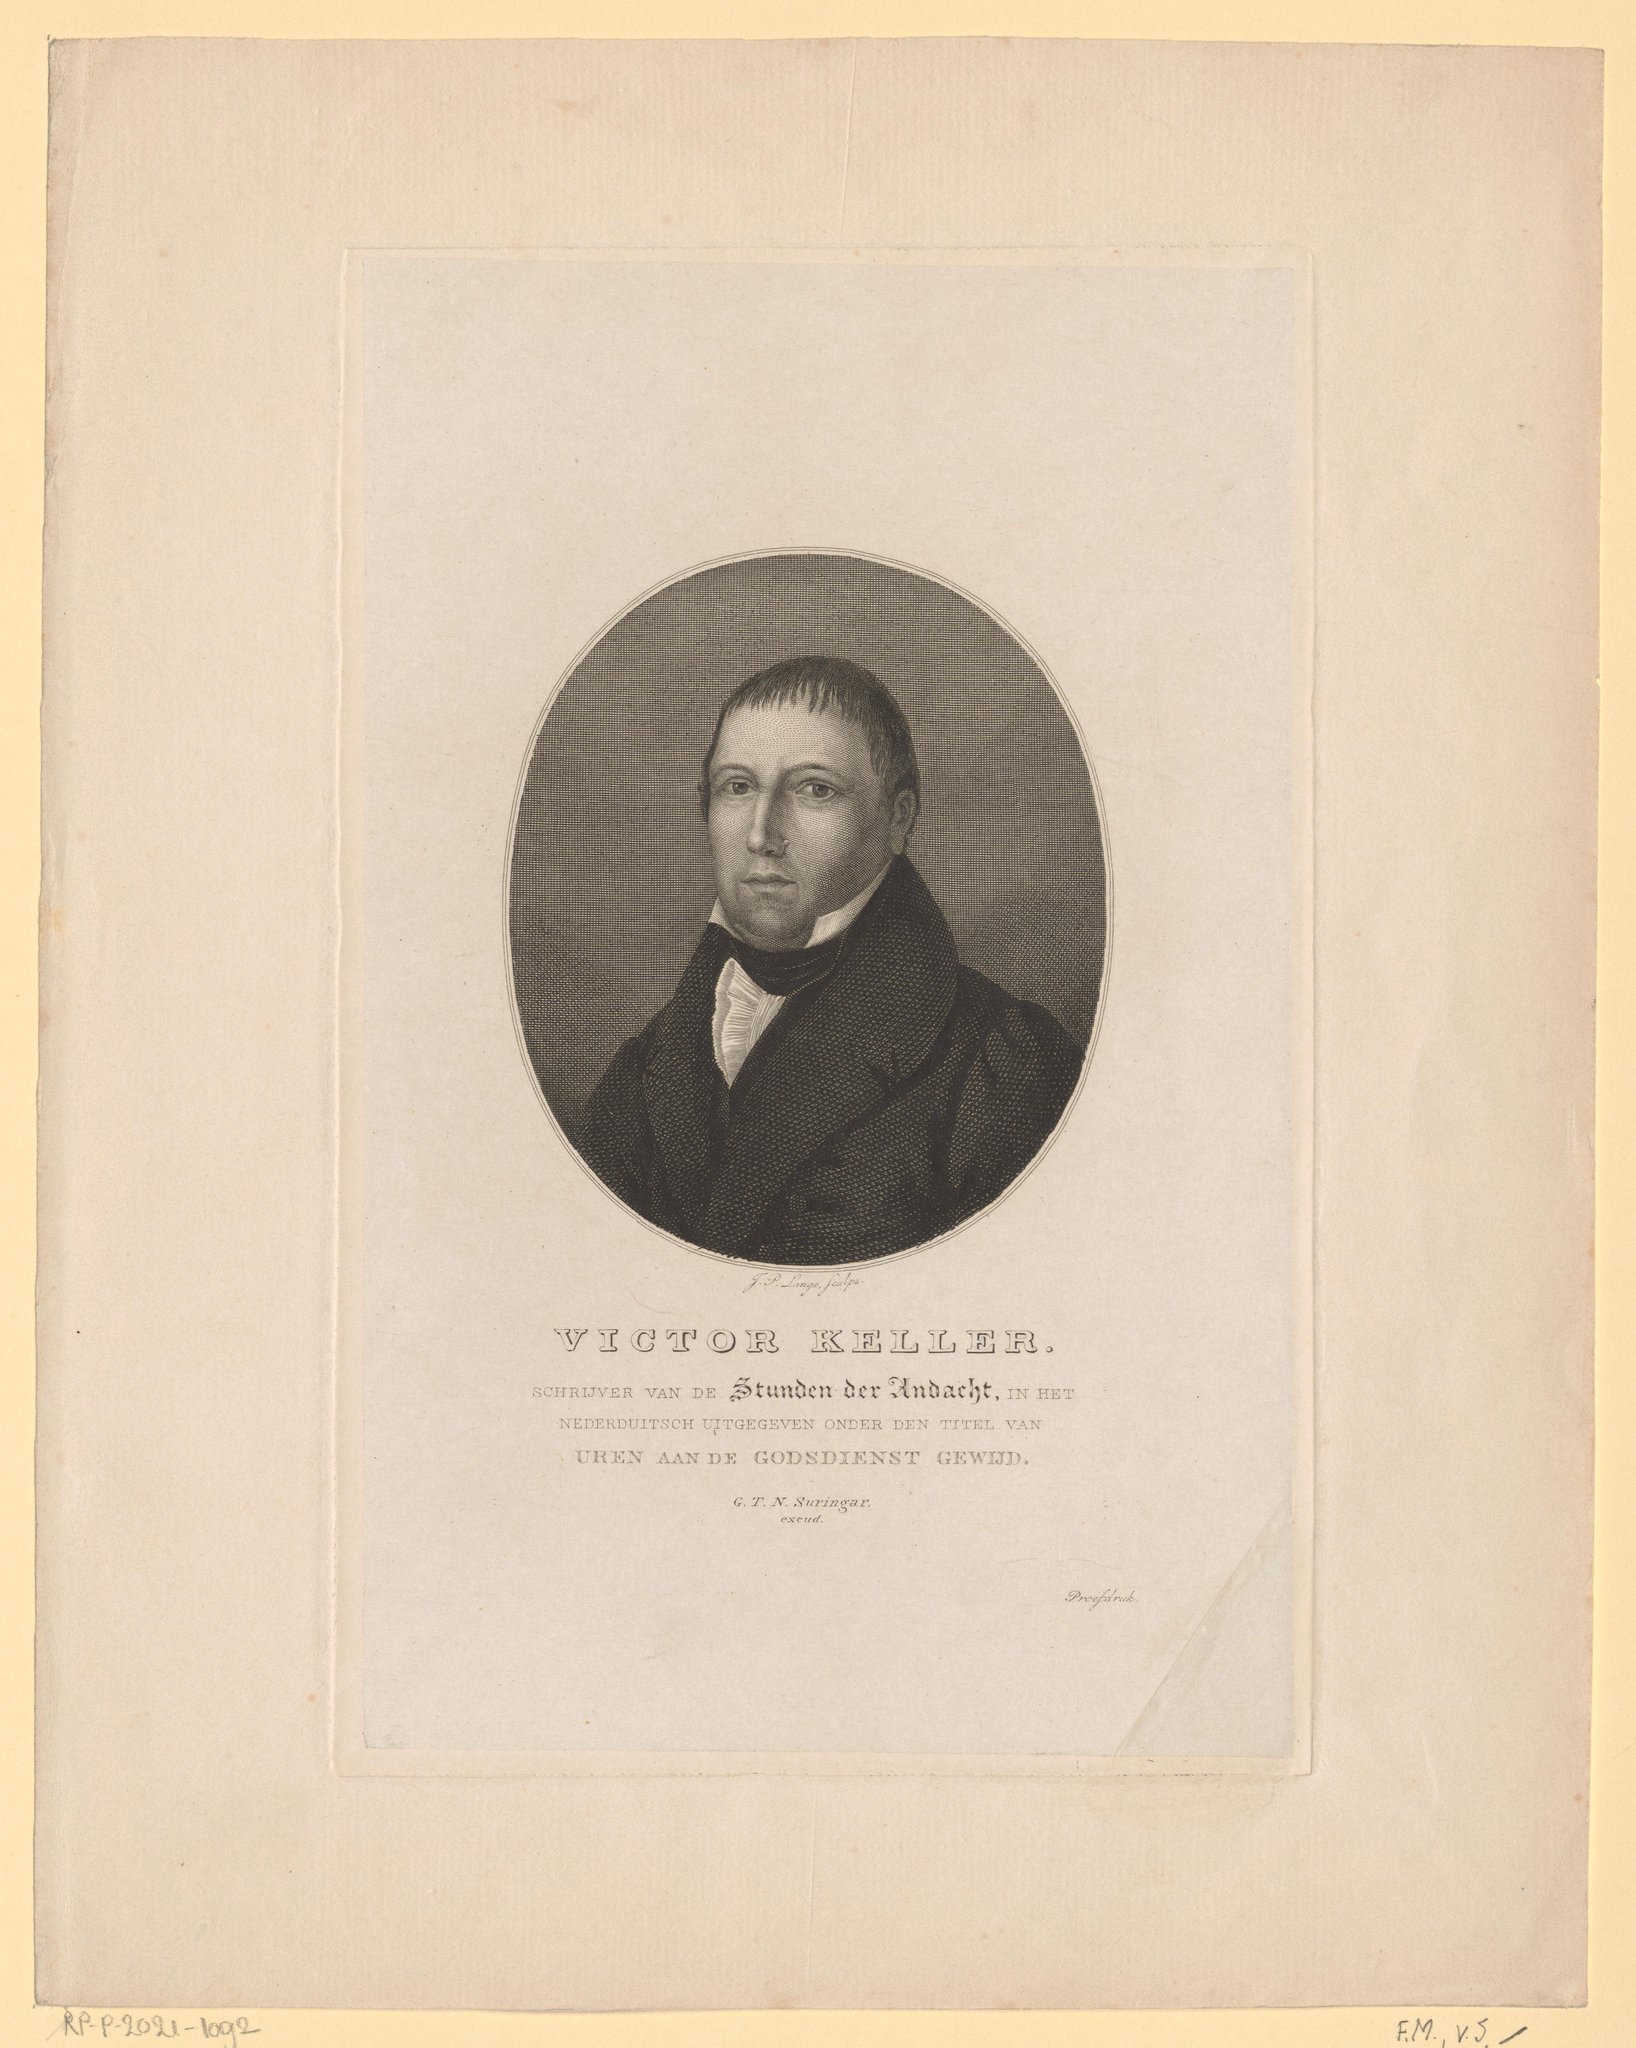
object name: print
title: Portret van Victor Keller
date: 1820-1849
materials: paper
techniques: engraving, etching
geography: leeuwarden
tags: historical persons